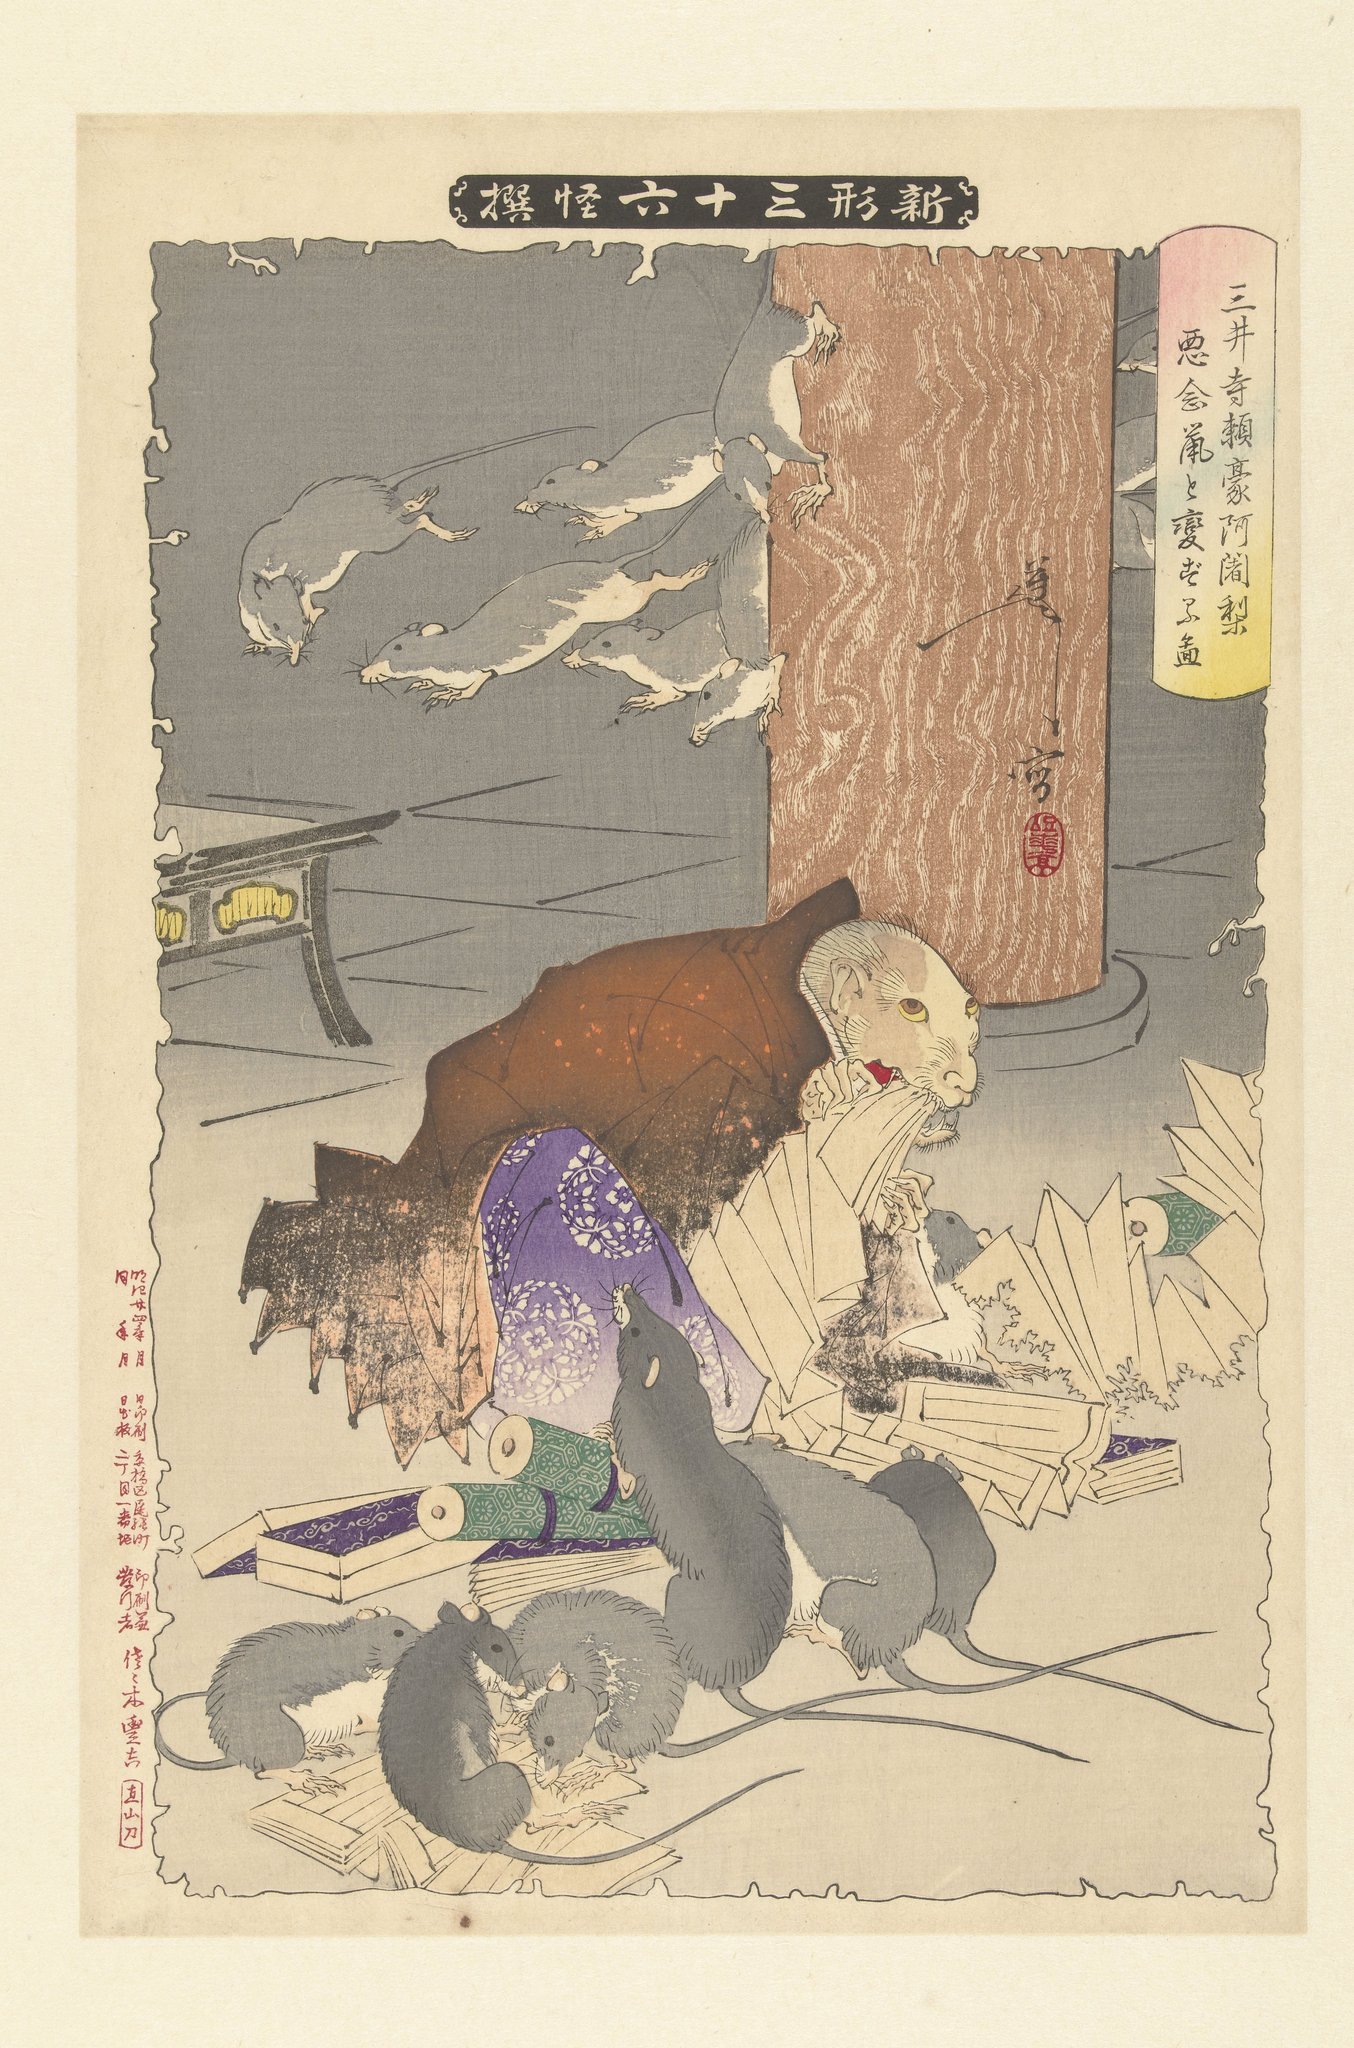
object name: print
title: Nieuwe verschijningen van 36 spoken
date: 1892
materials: paper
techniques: woodcut, nishiki e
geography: japan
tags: rodents: rat, transformation, metamorphosis of person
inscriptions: collector's mark: Lugt 2760, collector's mark: Lugt 2228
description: Een reusachtige rat in priesterskleding, samen met andere ratten, knagend aan boeken en handrollen. Raigo, priester van de Miidera tempel, veranderde na zijn dood in 1000 ratten die de heilige manuscripten van de tempel vernietigden.